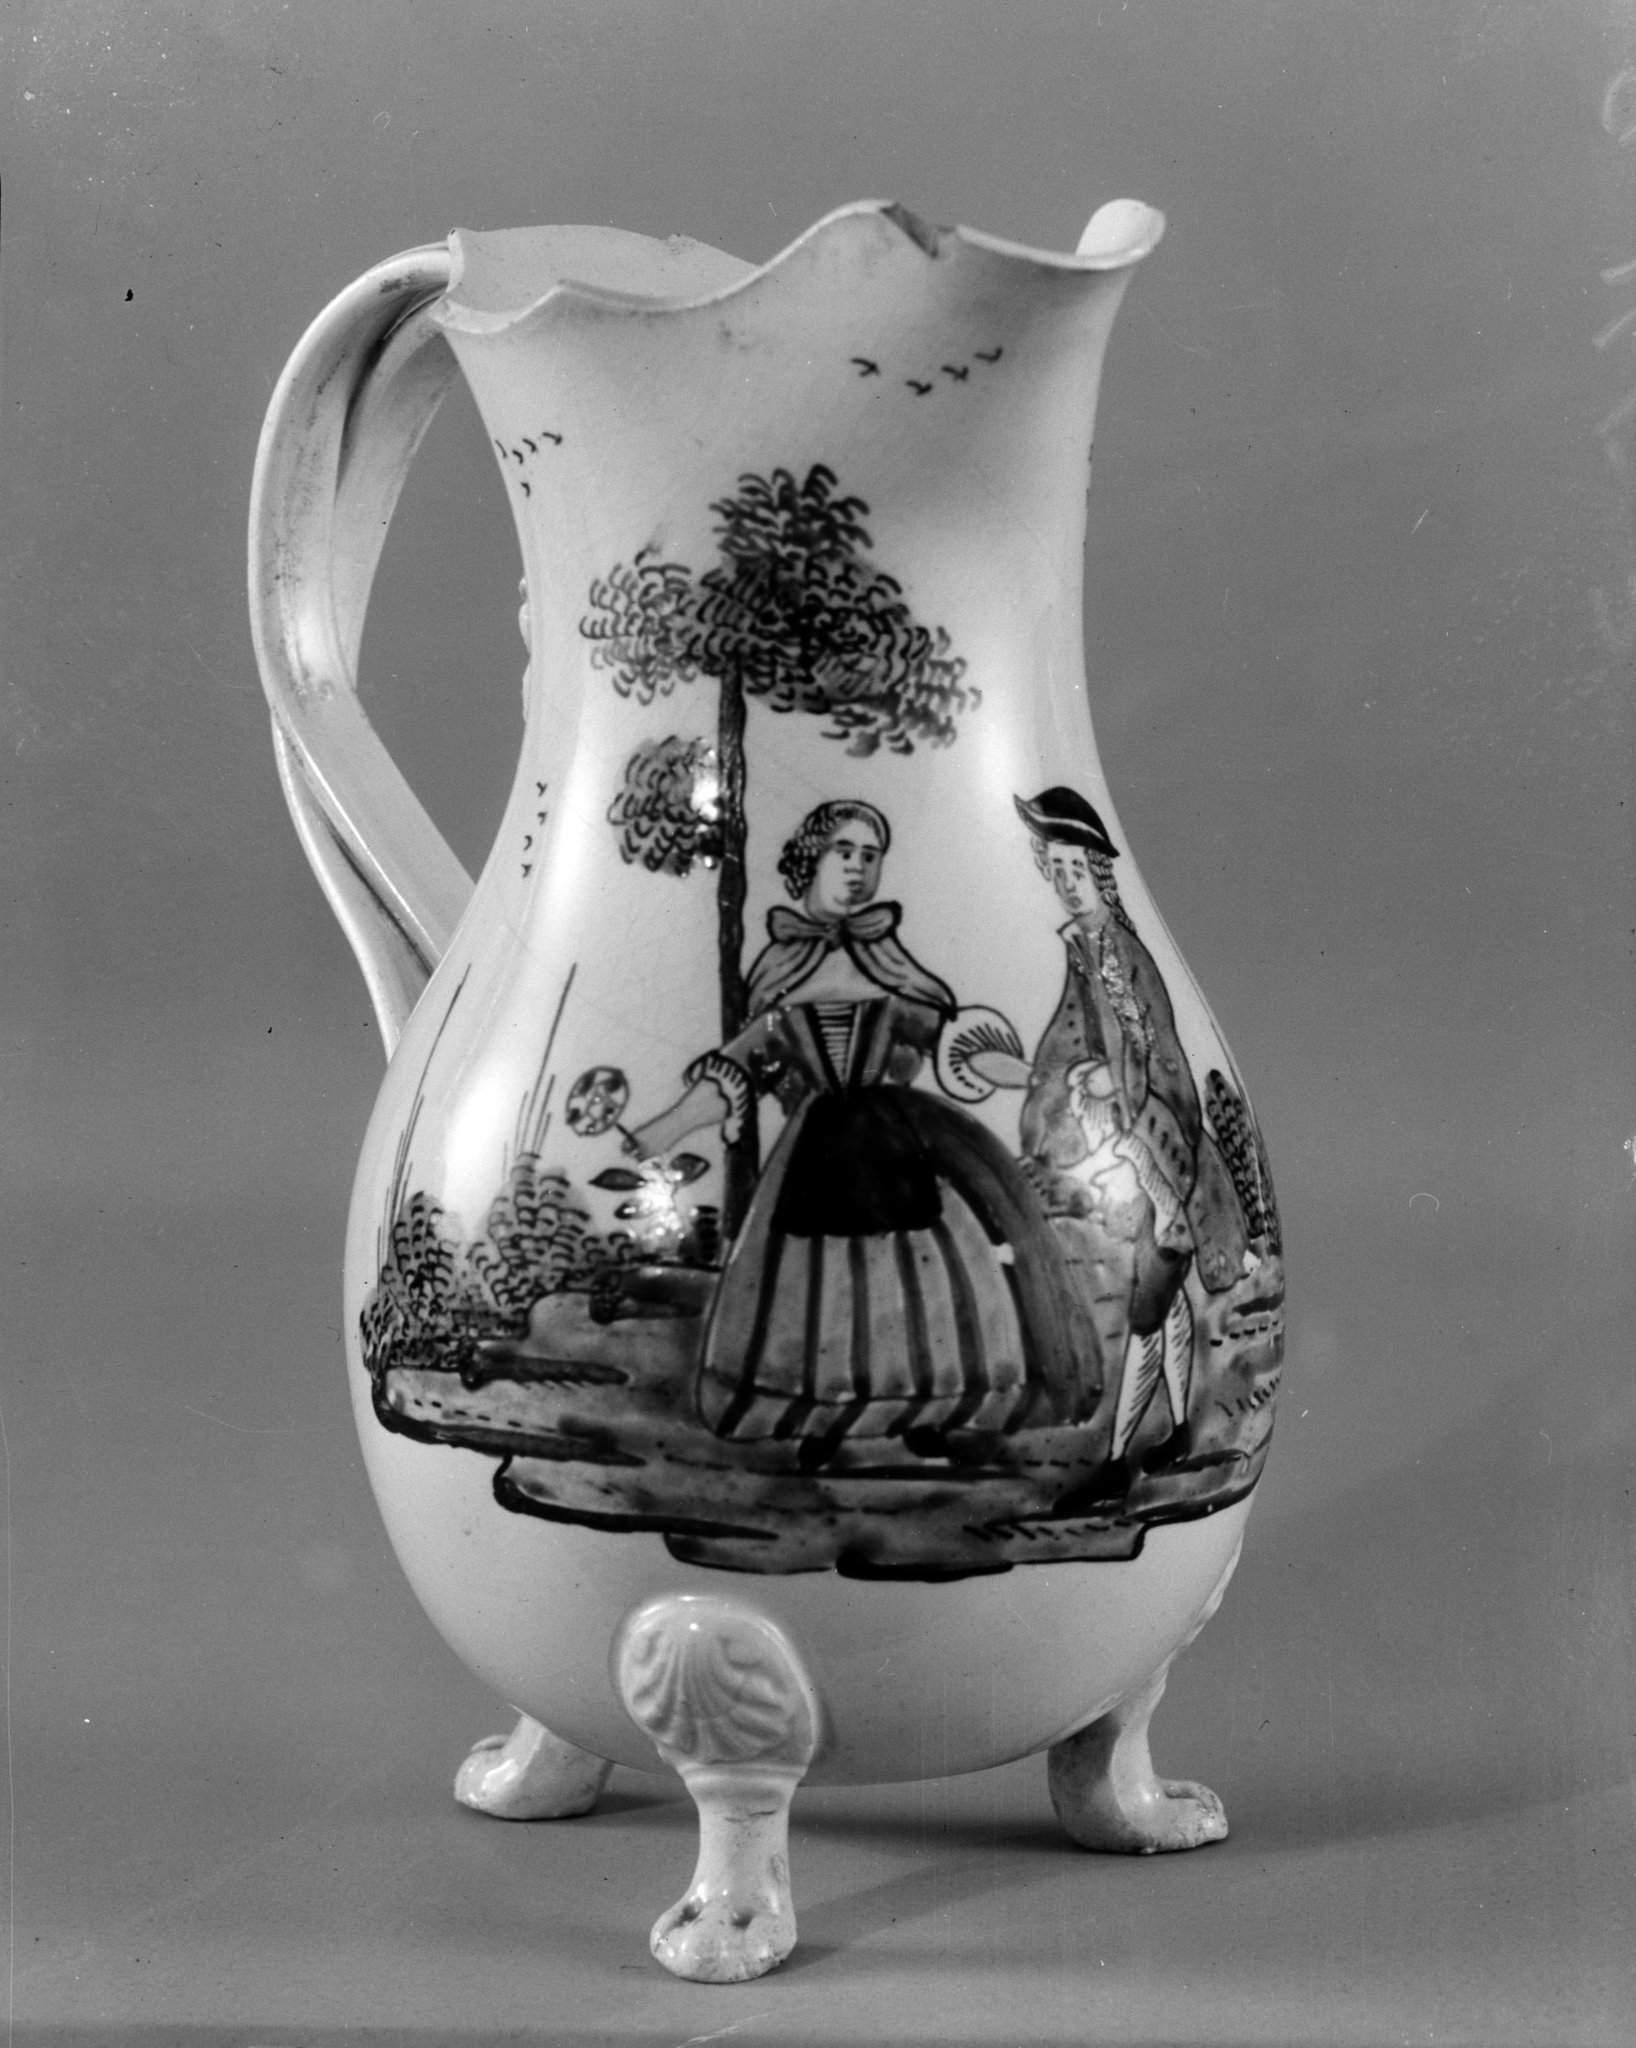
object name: milk pitcher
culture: british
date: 1770-1780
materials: earthenware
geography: england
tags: men,women